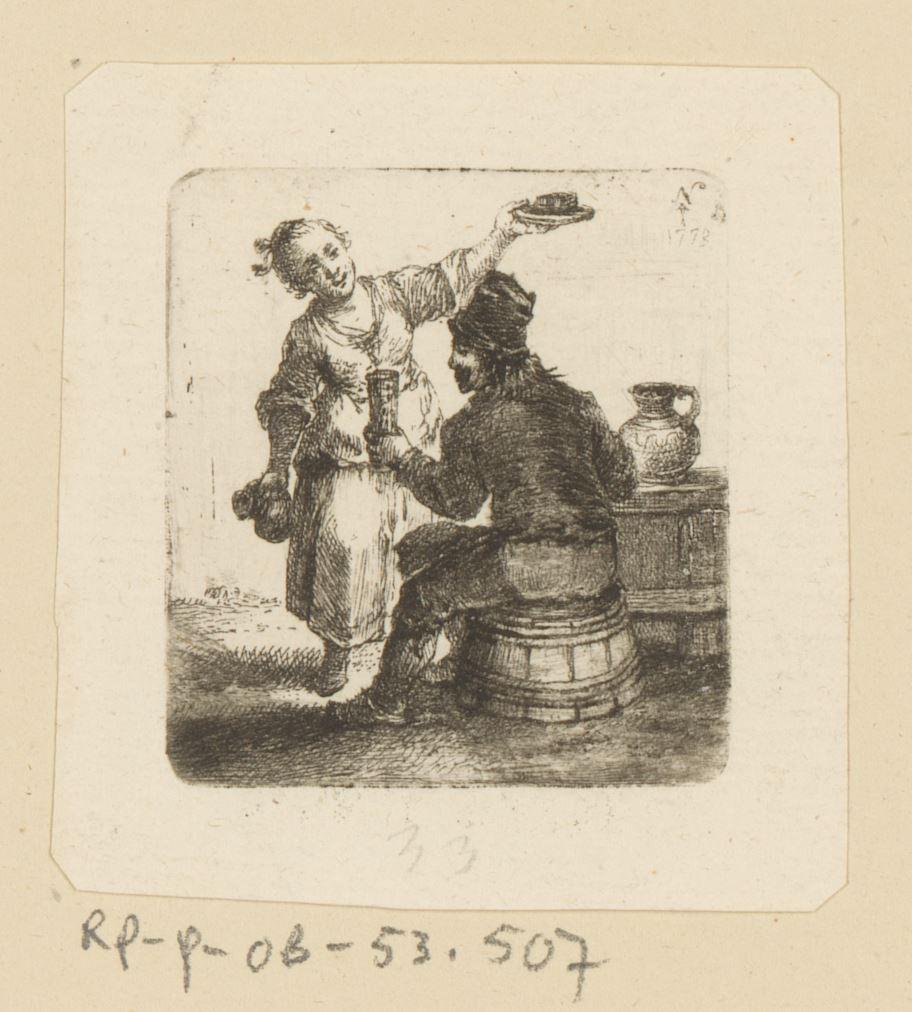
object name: print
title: Zittende man met beker en vrouw met kruik en bord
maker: johann andreas benjamin nothnagel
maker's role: print maker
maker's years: 1729-1804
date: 1773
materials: paper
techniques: etching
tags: giving drink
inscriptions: collector's mark: Lugt 240